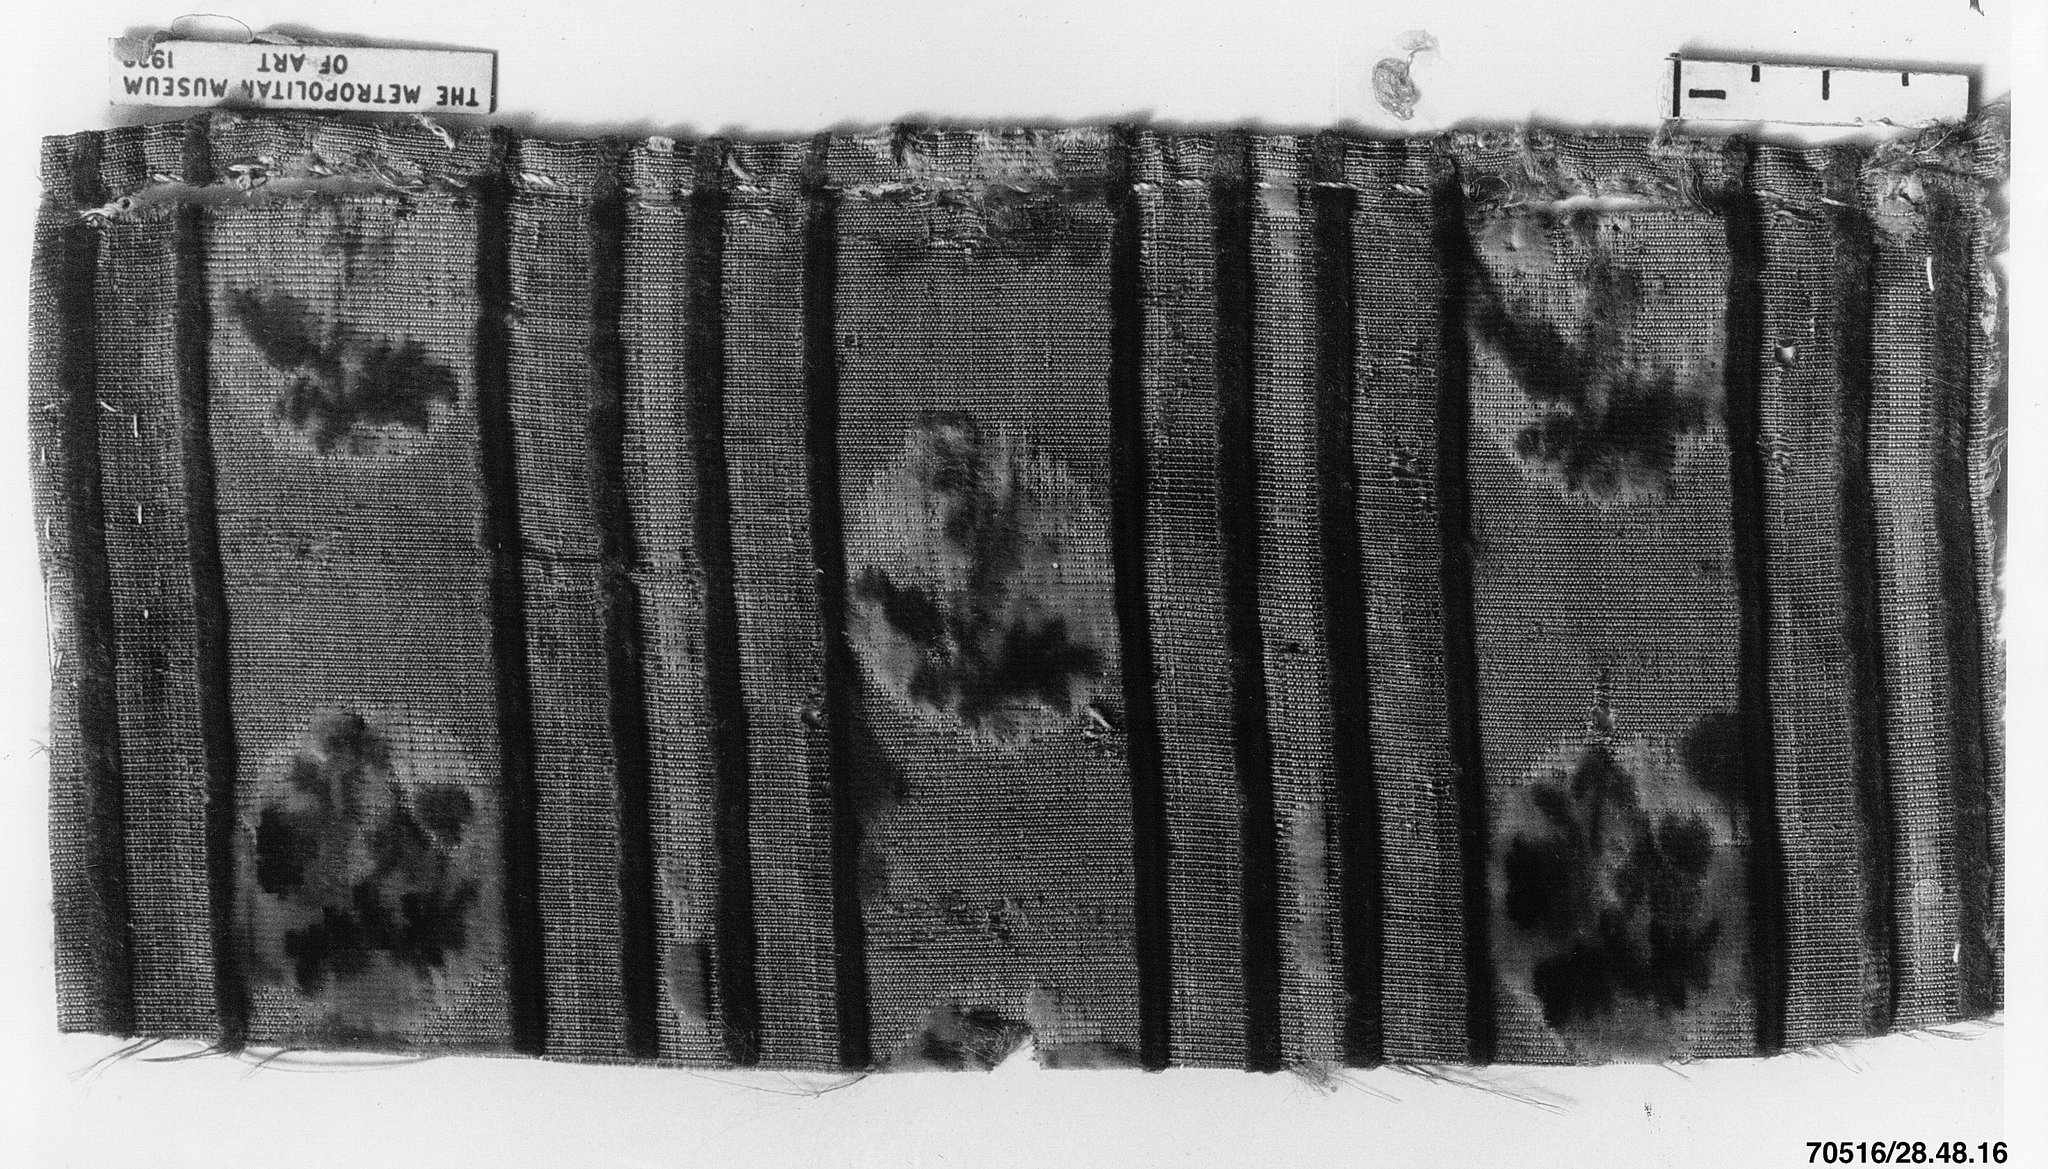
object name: fragment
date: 1767-1800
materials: metal thread, silk